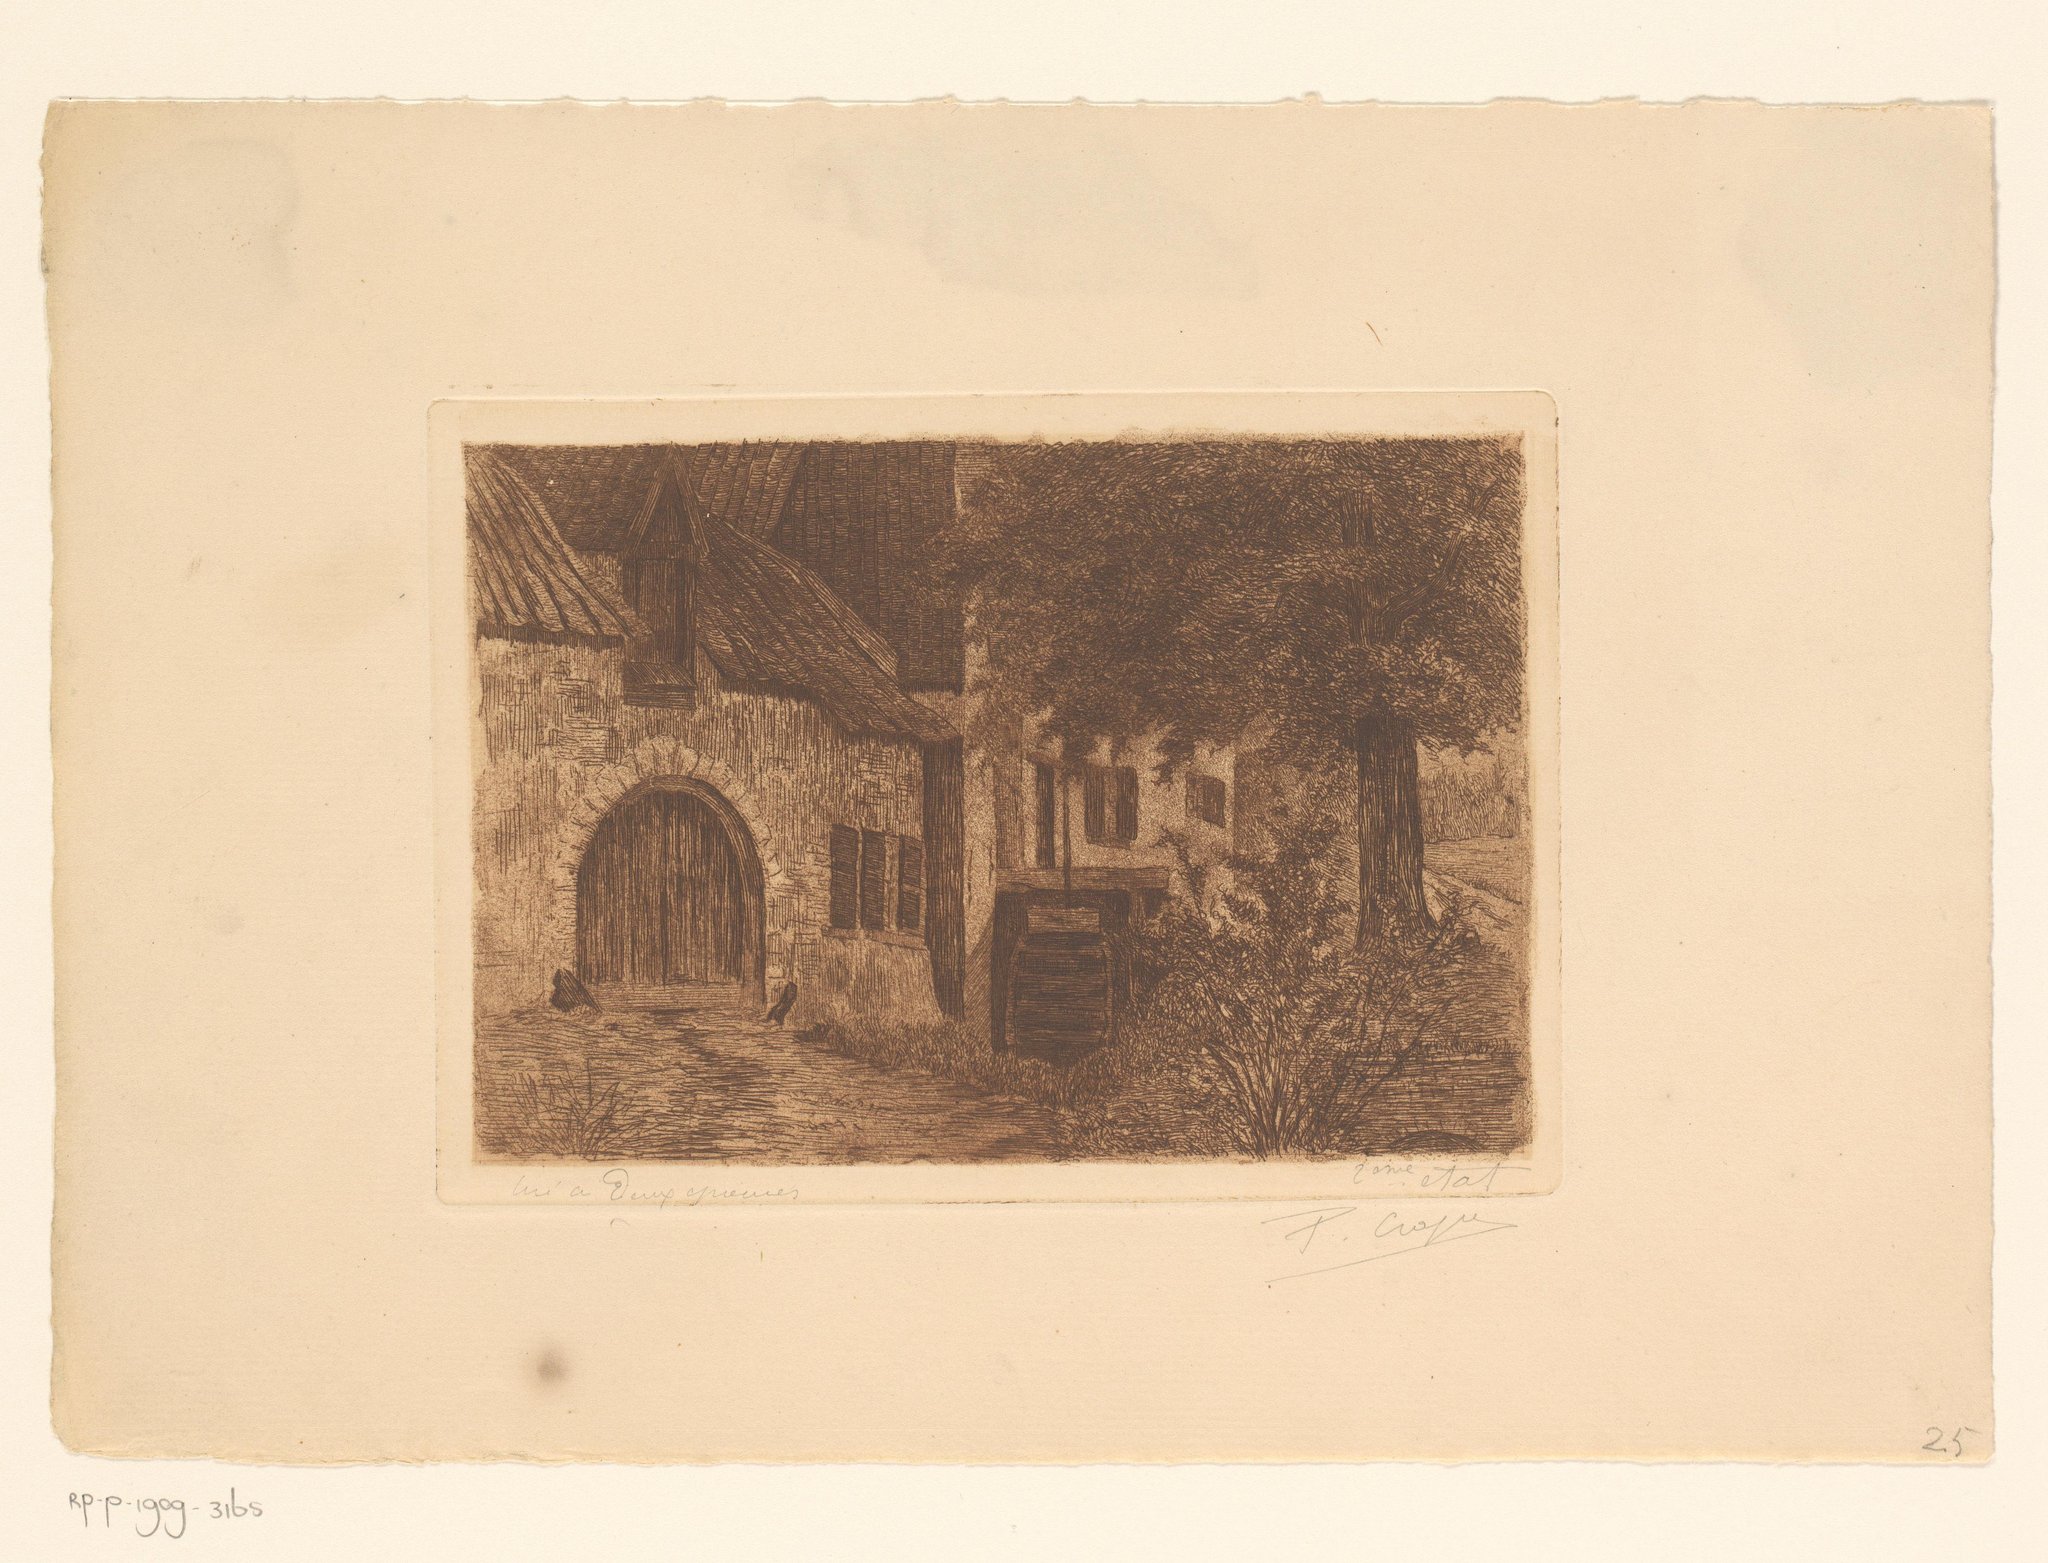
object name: print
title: Gezicht op een boerderij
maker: pol craps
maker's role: print maker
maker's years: 1877-1939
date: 1887-1909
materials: paper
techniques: drypoint, etching, intaglio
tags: farm or solitary house in landscape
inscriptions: collector's mark: Lugt 2228, annotation: ‘tiré a deux epreuves; 2eme etat’